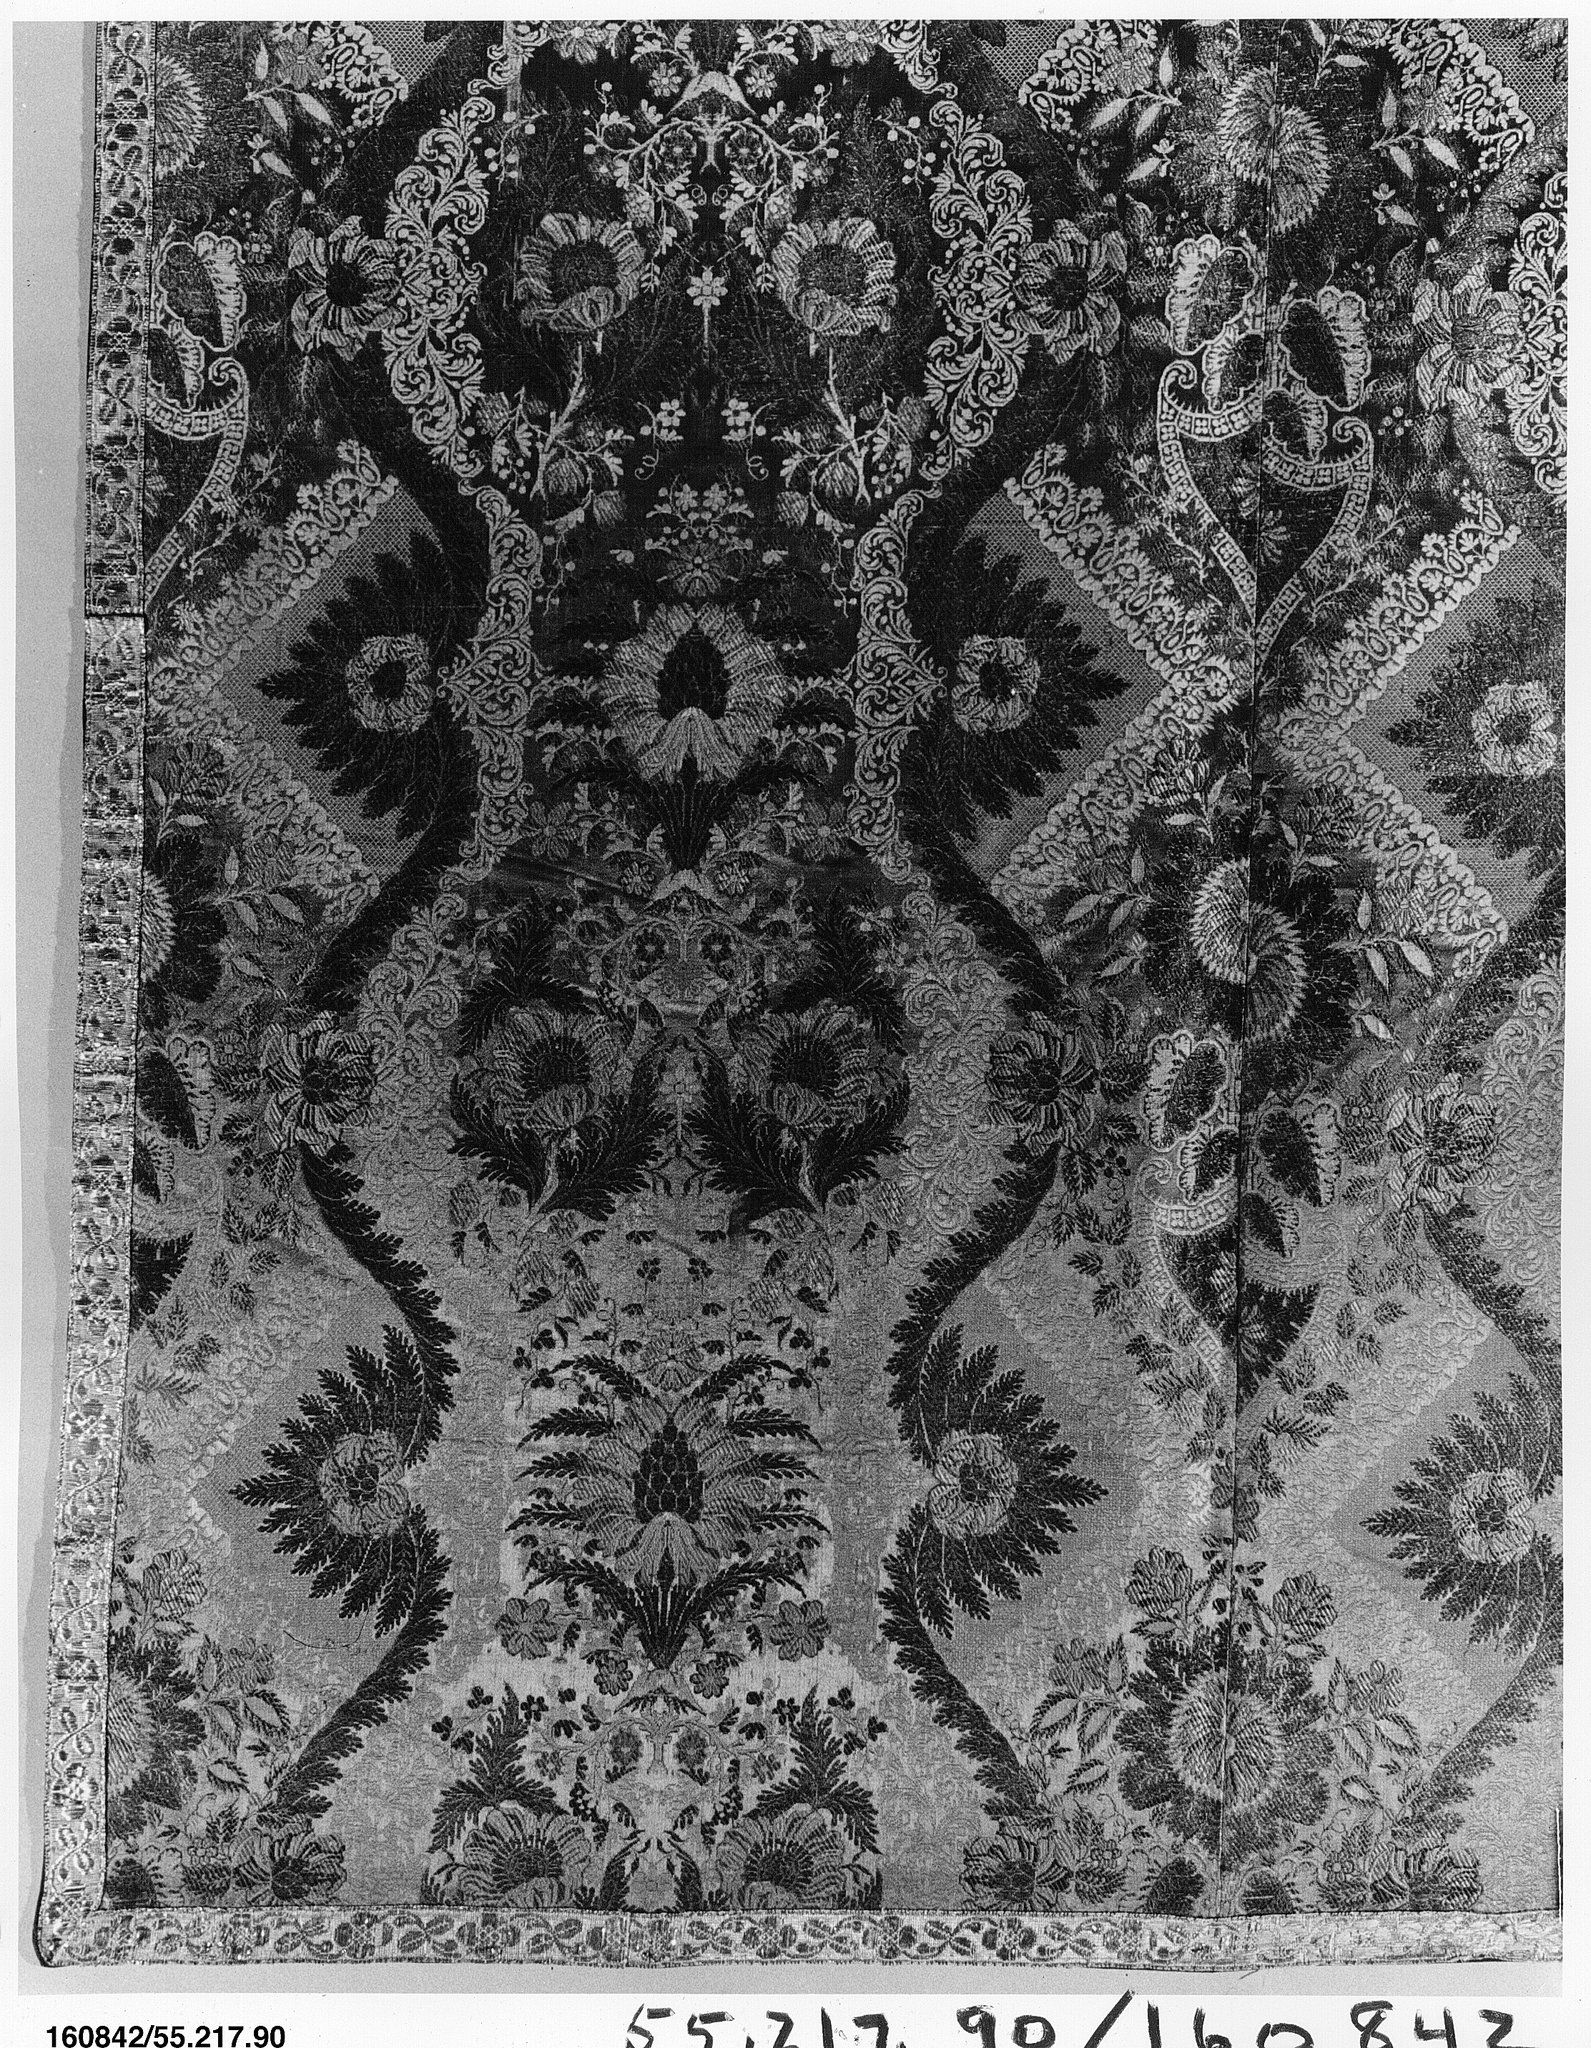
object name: piece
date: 1725-1730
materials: metal thread, silk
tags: flowers,leaves